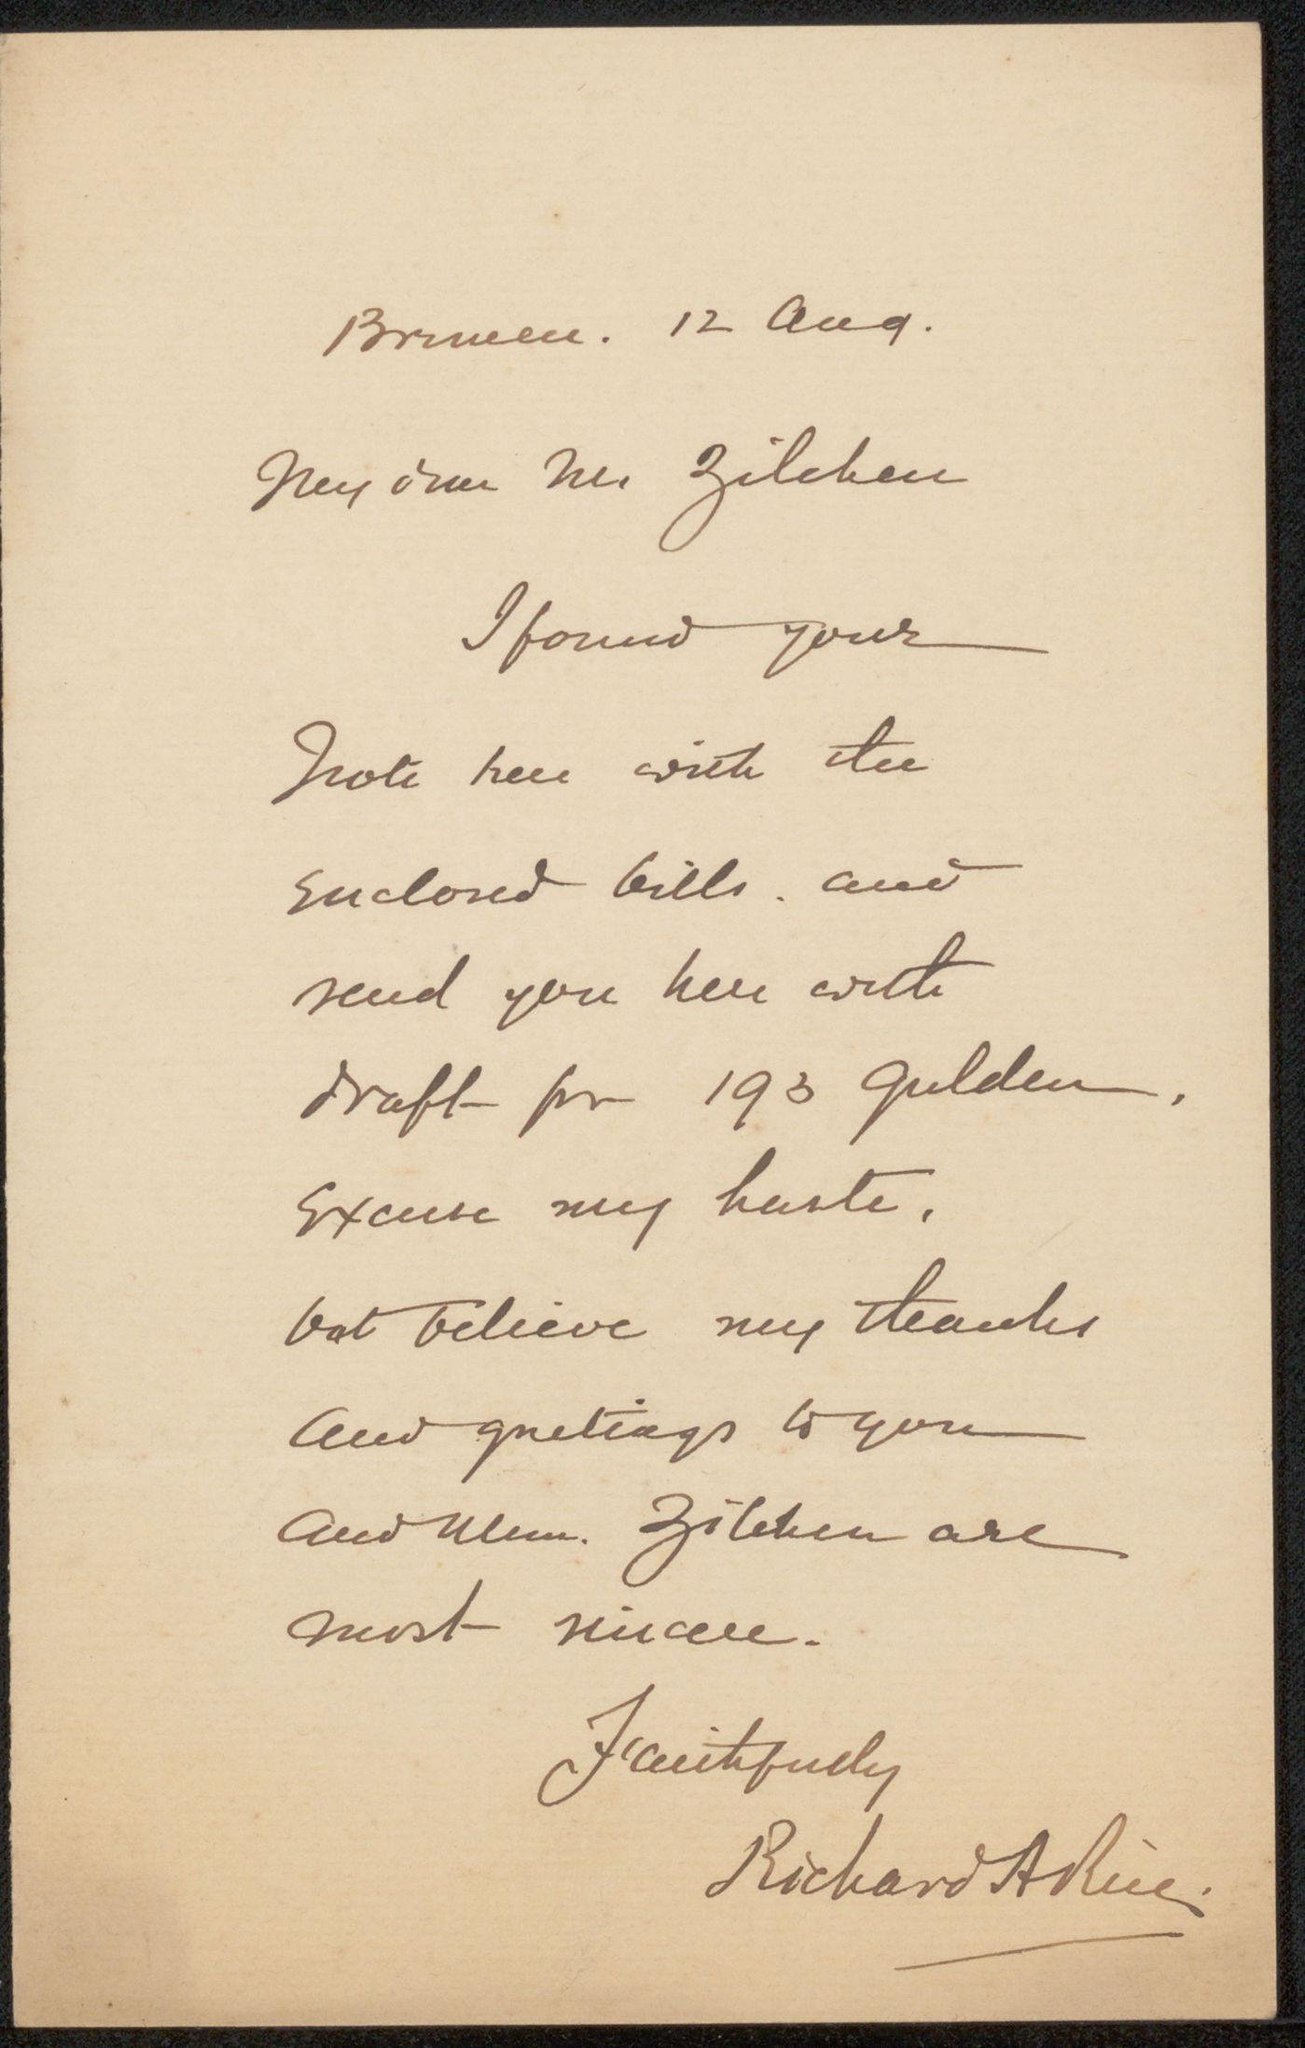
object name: letter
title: Brief aan Philip Zilcken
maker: richard austin rice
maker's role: professor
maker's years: 1846-1925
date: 1867-1925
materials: ink, paper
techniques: pen, writing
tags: draughtsman, philip zilcken, money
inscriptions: watermark